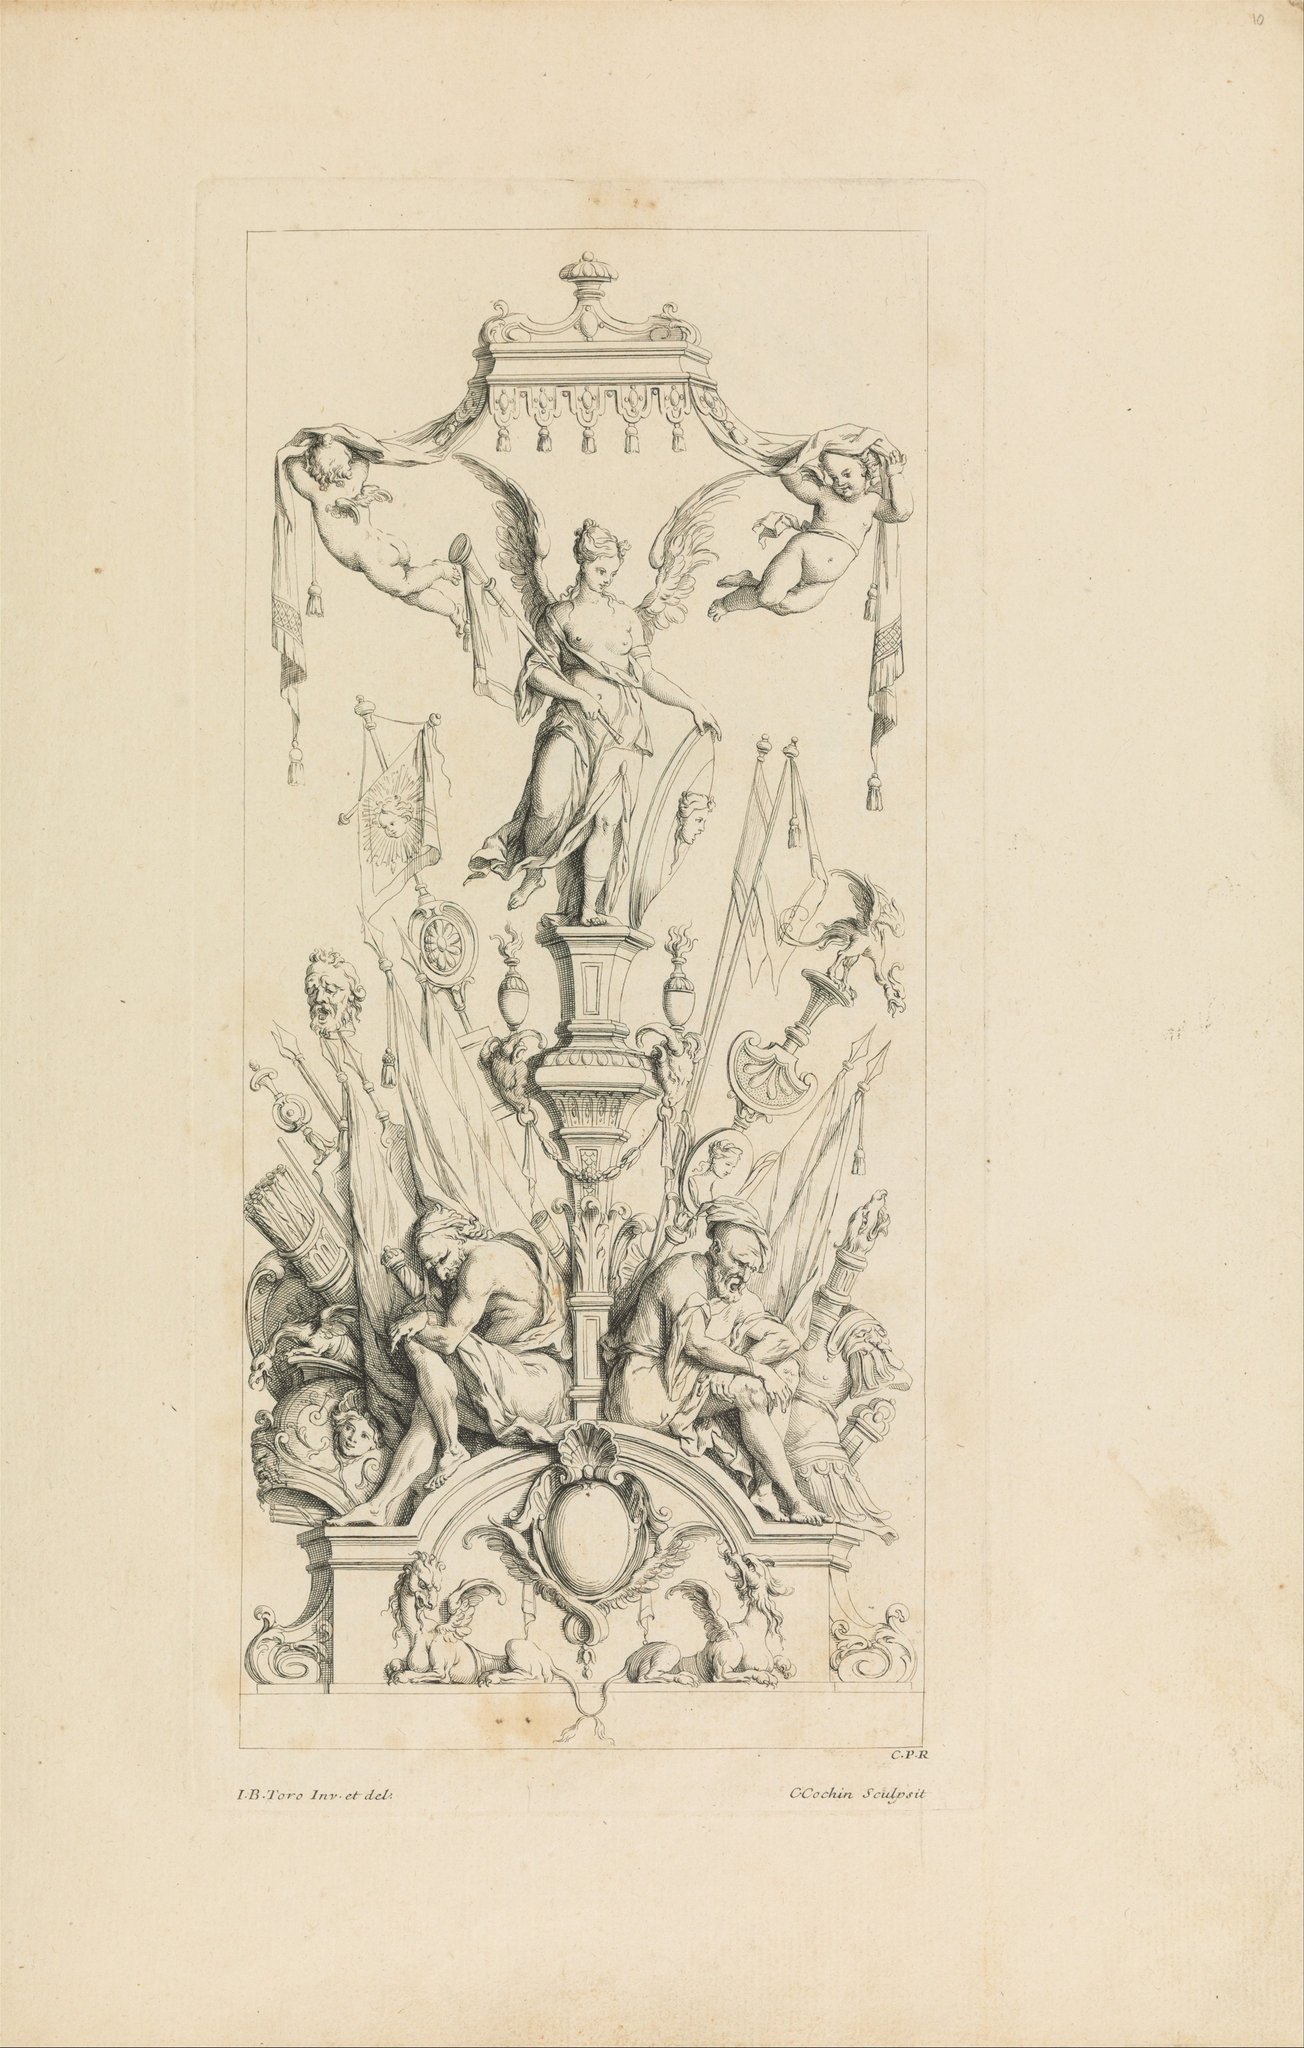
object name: album print ornament architecture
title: Trophées Nouvellement Inventez par J.B. Toro.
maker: jean bernard toro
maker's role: designer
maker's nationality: french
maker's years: 1672-1731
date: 1716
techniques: etching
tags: men,flags,trophies